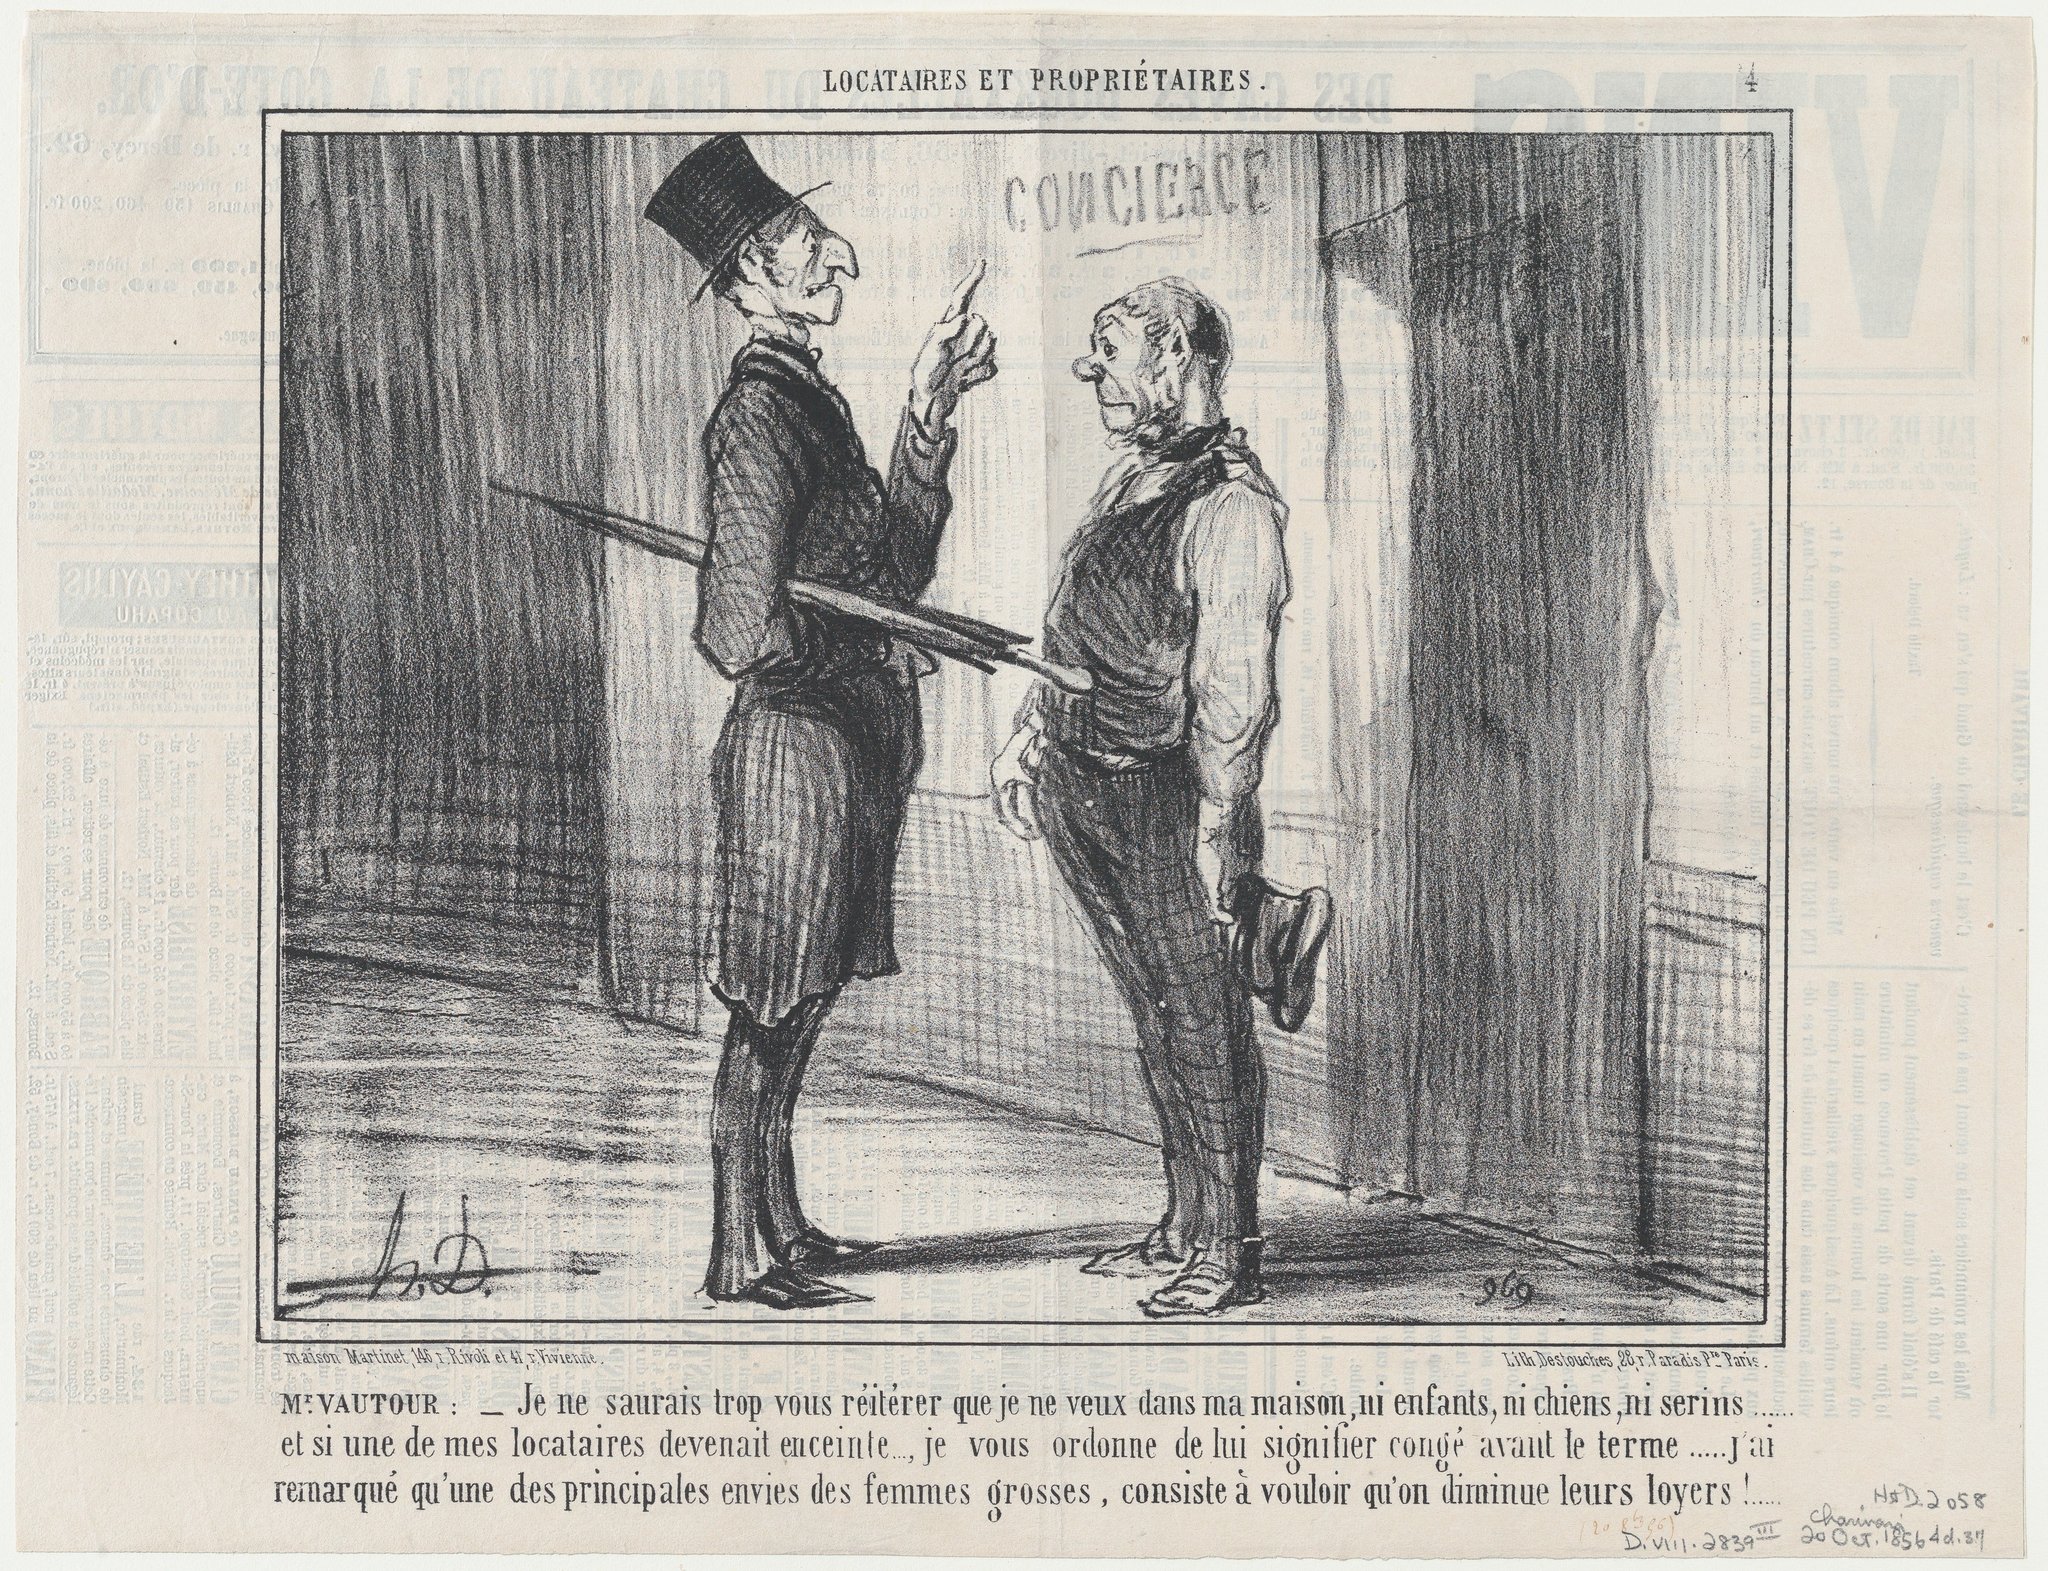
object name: print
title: Mr. Vautour: –Je ne saurais trop..., from Locataires et Propriétaires, published in Le Charivari, October 20, 1856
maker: honoré daumier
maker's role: artist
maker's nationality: french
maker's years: 1808-1879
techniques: lithograph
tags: satire,men